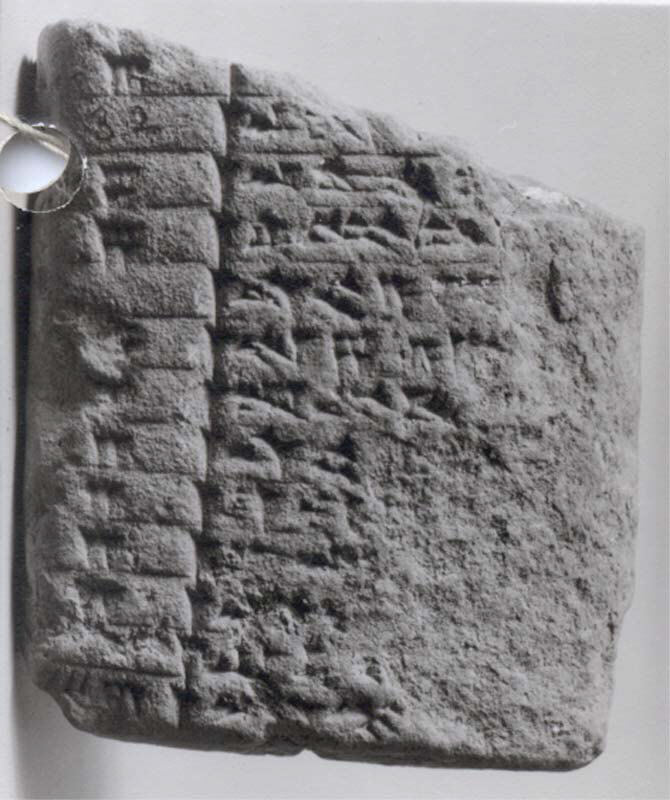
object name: cuneiform tablet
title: Cuneiform tablet: account, Ebabbar archive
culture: babylonian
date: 626-539 BCE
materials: clay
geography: mesopotamia